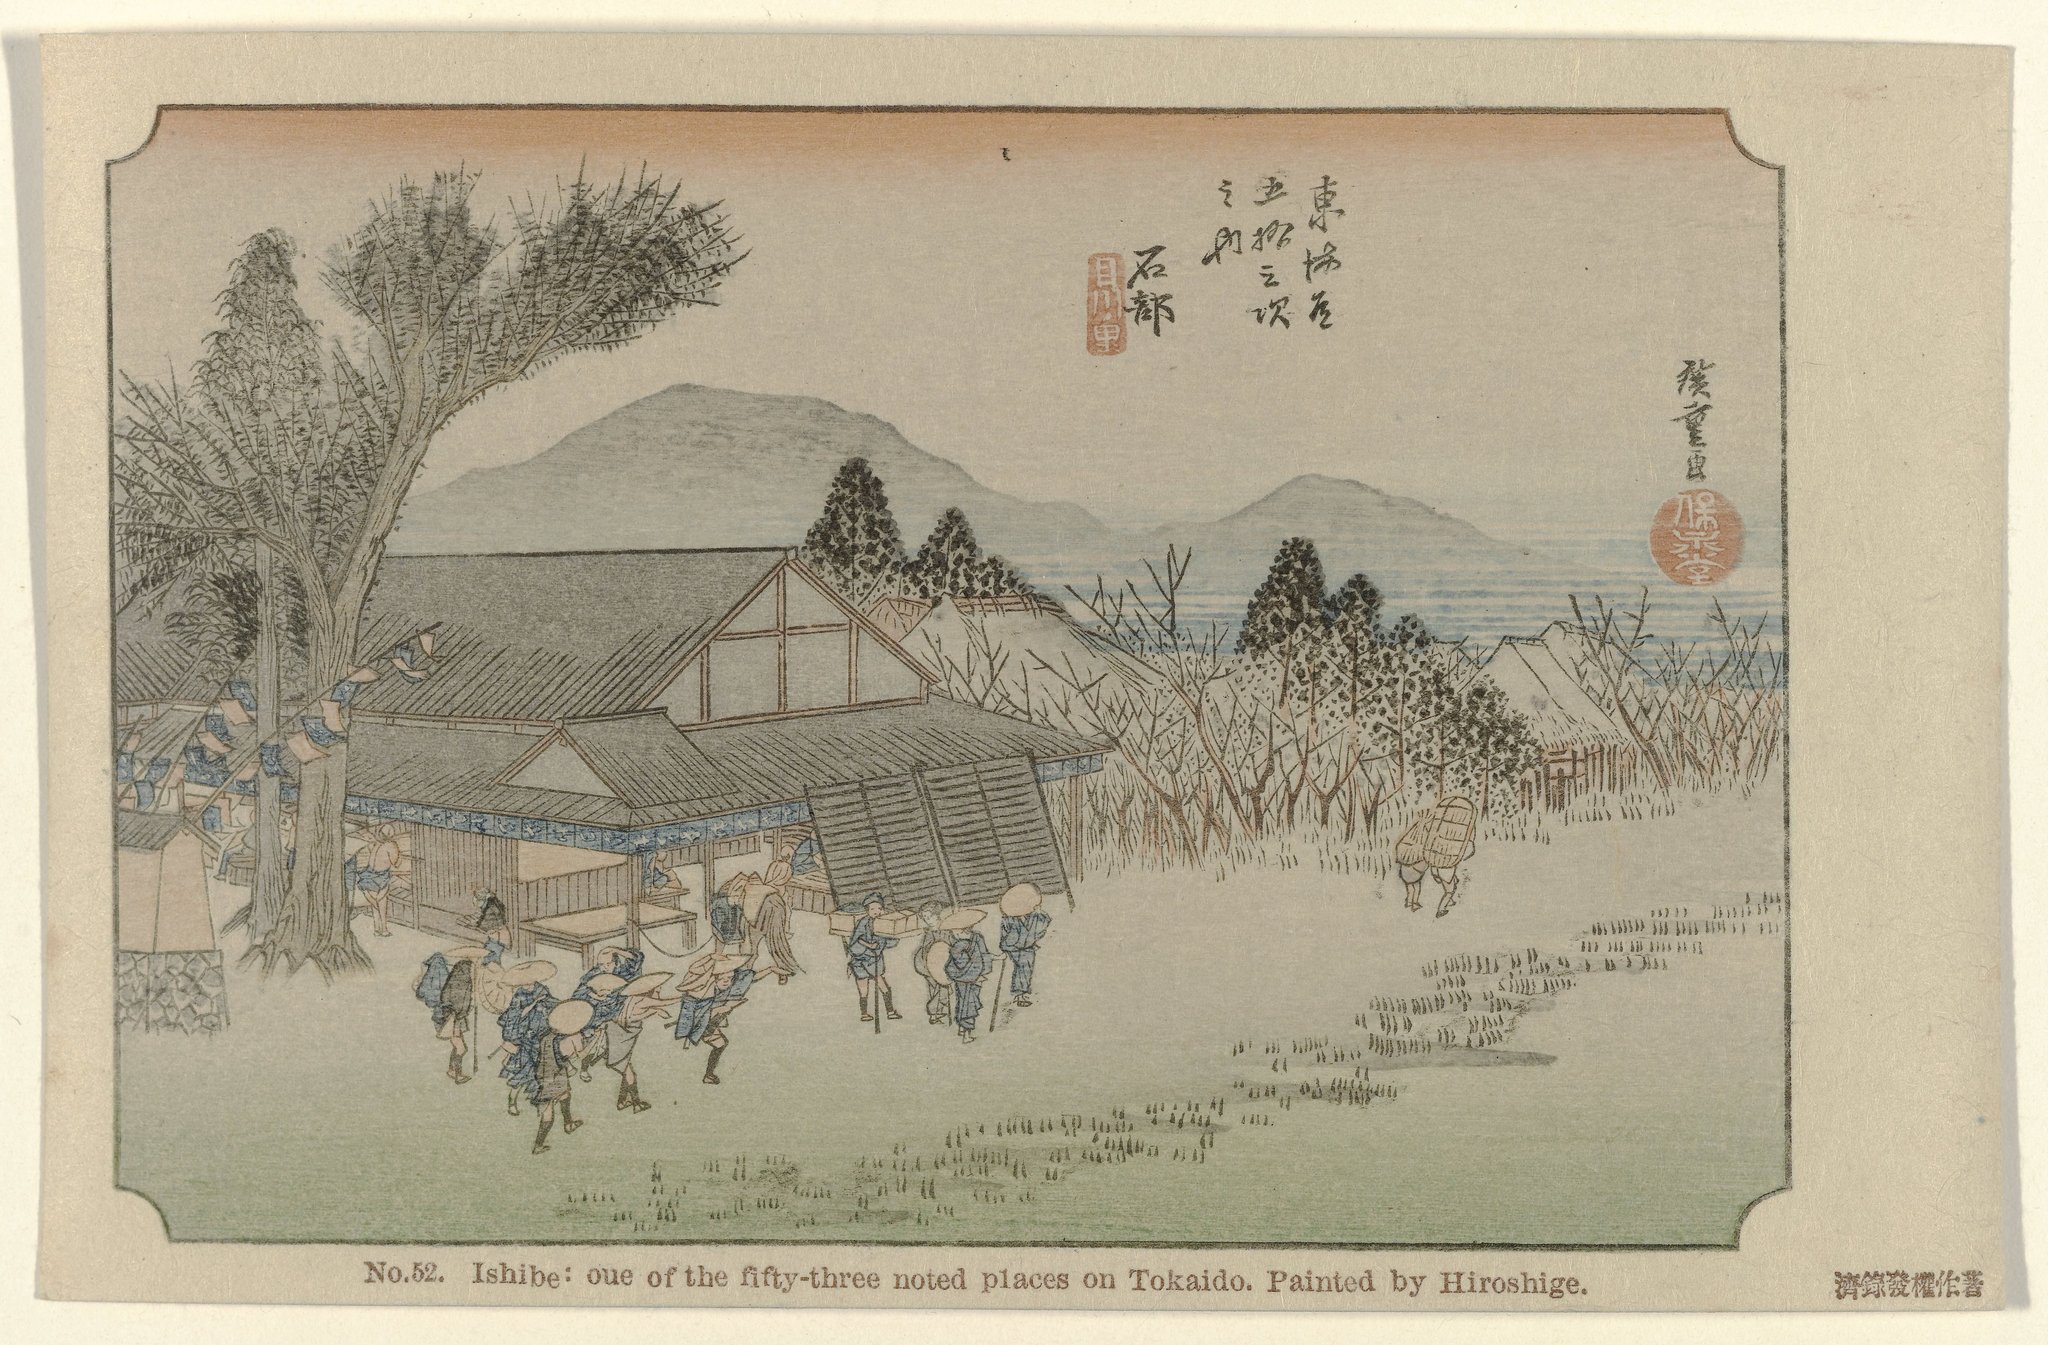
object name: ansichtkaart, prentbriefkaart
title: Hiroshige no fude Tôkaidô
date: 1906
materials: cardboard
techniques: woodcut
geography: japan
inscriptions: date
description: Reizgers passeren een rustplek langs de Tôkaidô.